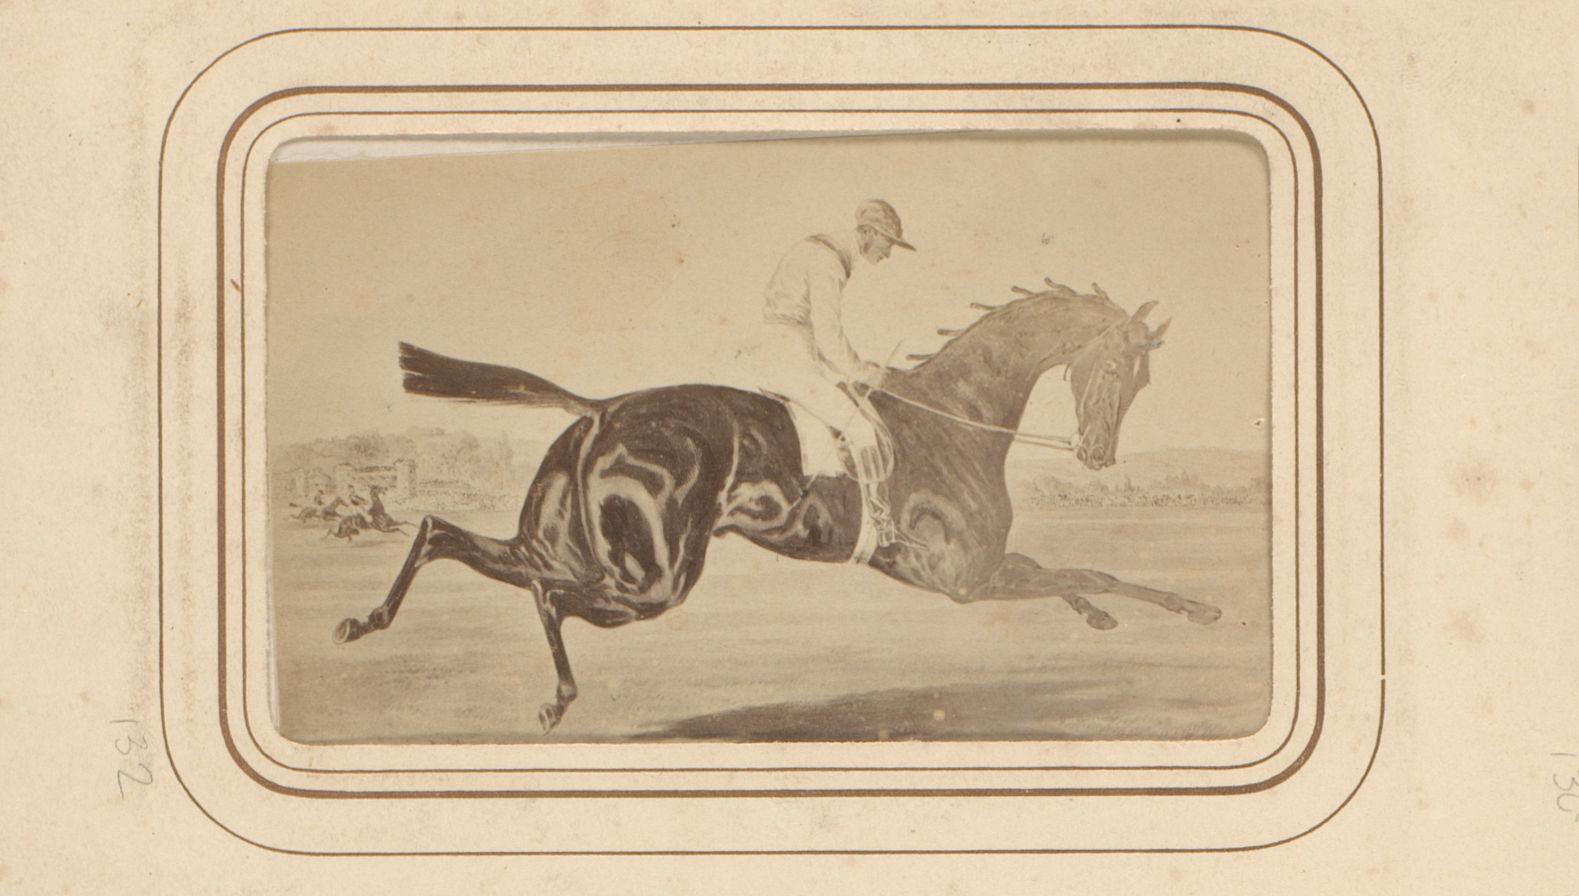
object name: photograph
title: Fotoreproductie van ontwerp met de voorstelling van een ruiter te paard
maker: Anonymous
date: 1865-1890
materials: cardboard, photographic support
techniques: albumen print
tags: horse-racing, painting, drawing and the graphic arts